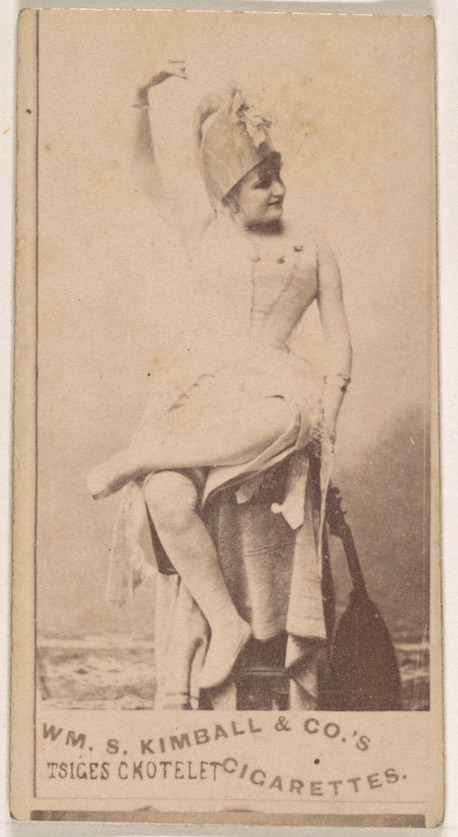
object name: photograph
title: Tsiges Ckotelet, from the Actresses series (N203) issued by Wm. S. Kimball & Co.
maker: william s. kimball & company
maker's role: publisher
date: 1889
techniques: color lithograph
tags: portraits,women,actresses